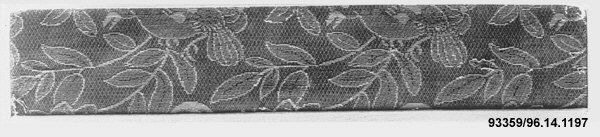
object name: piece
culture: japanese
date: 1701-1900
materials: silk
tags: leaves